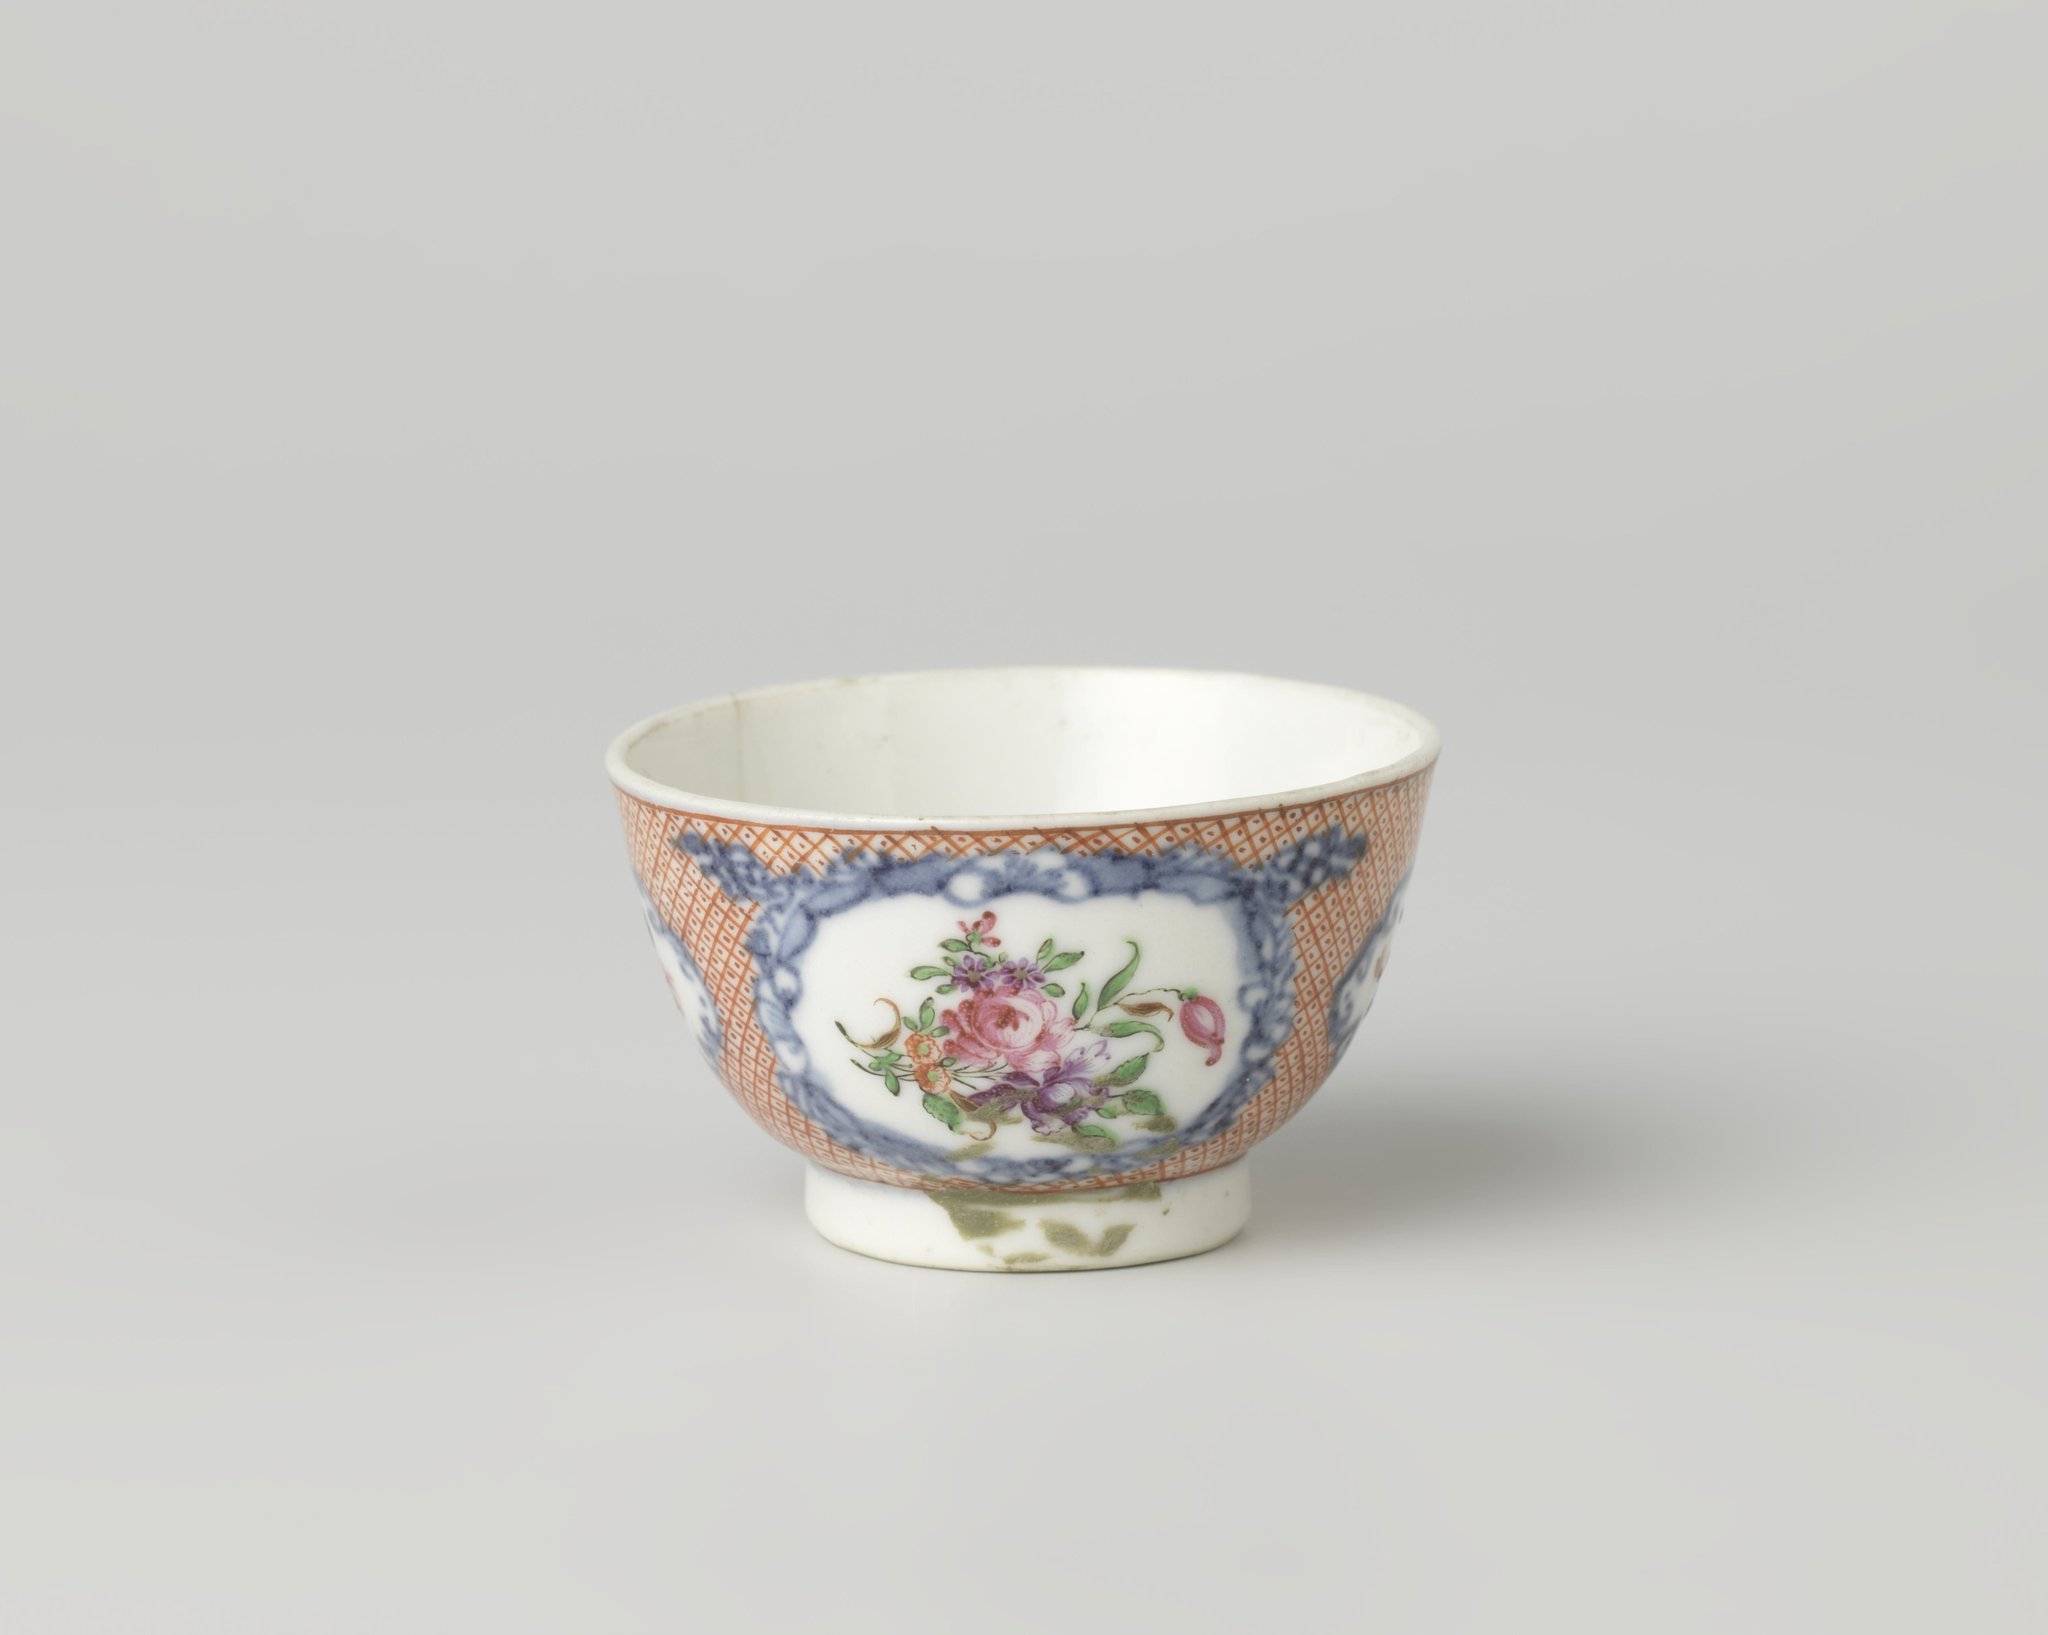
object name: kop en schotel, kop en schotel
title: Cup with flower sprays in panels on a ground of red diaper pattern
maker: Anonymous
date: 1750-1774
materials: cobalt, glaze, paint, porcelain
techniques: firing, turning, vitrification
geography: china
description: Kop van porselein met rechte wand, beschilderd in onderglazuur blauw en op het glazuur rood, roze, groen, paars en zwart. Een cartouche in onderglazuur blauw met een bloemtak afgebeeld; de binnenwand met rood servetwerk met hierin uitgespaard vier kleinere cartouches met bloemtak. Een barst in de wan. Famille rose.